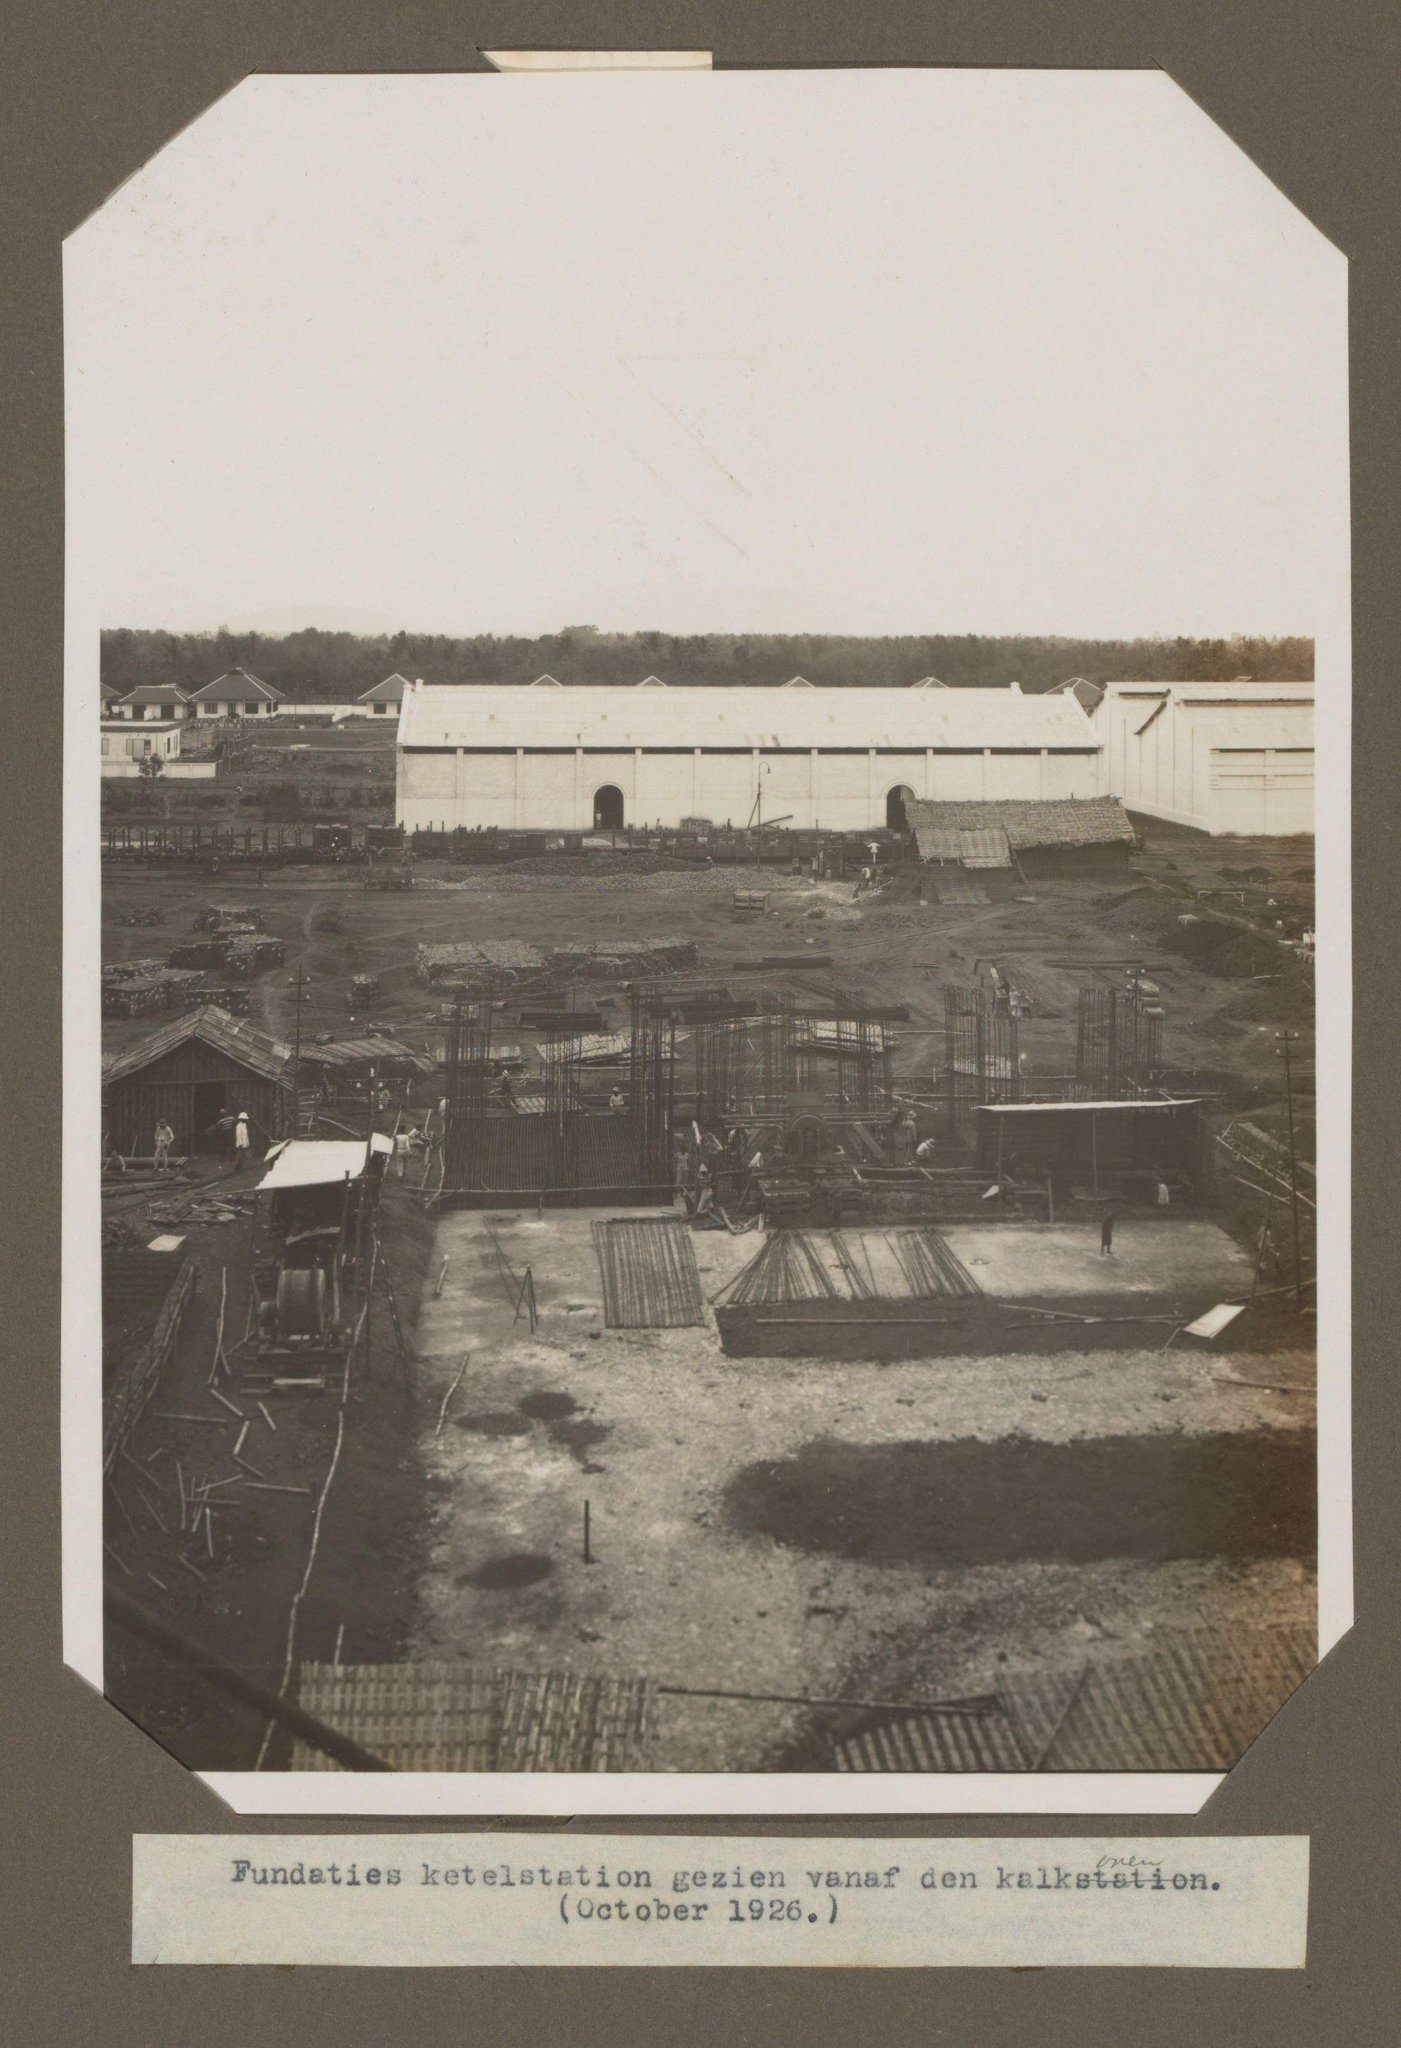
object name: photograph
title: Fundaties ketelstation gezien vanaf den kalkoven. (October 1926.)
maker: Anonymous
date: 1910-1926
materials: photographic support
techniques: gelatin silver print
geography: east java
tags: colonial system, trade-company, industrial structures, (non-fruit) products of plants or trees: sugarcane, laying the foundations; trench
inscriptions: inscription: ‘Fundaties ketelstation gezien vanaf den kalkstation. (October 1926.)’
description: Zicht op de funderingen voor het ketelstation voor de fabriek, oktober 1926. Onderdeel van het fotoalbum met foto's van de opbouw van de suikerfabriek te Goenoengsari op Oost-Java door de Handels Vereniging Amsterdam 1926-1927.